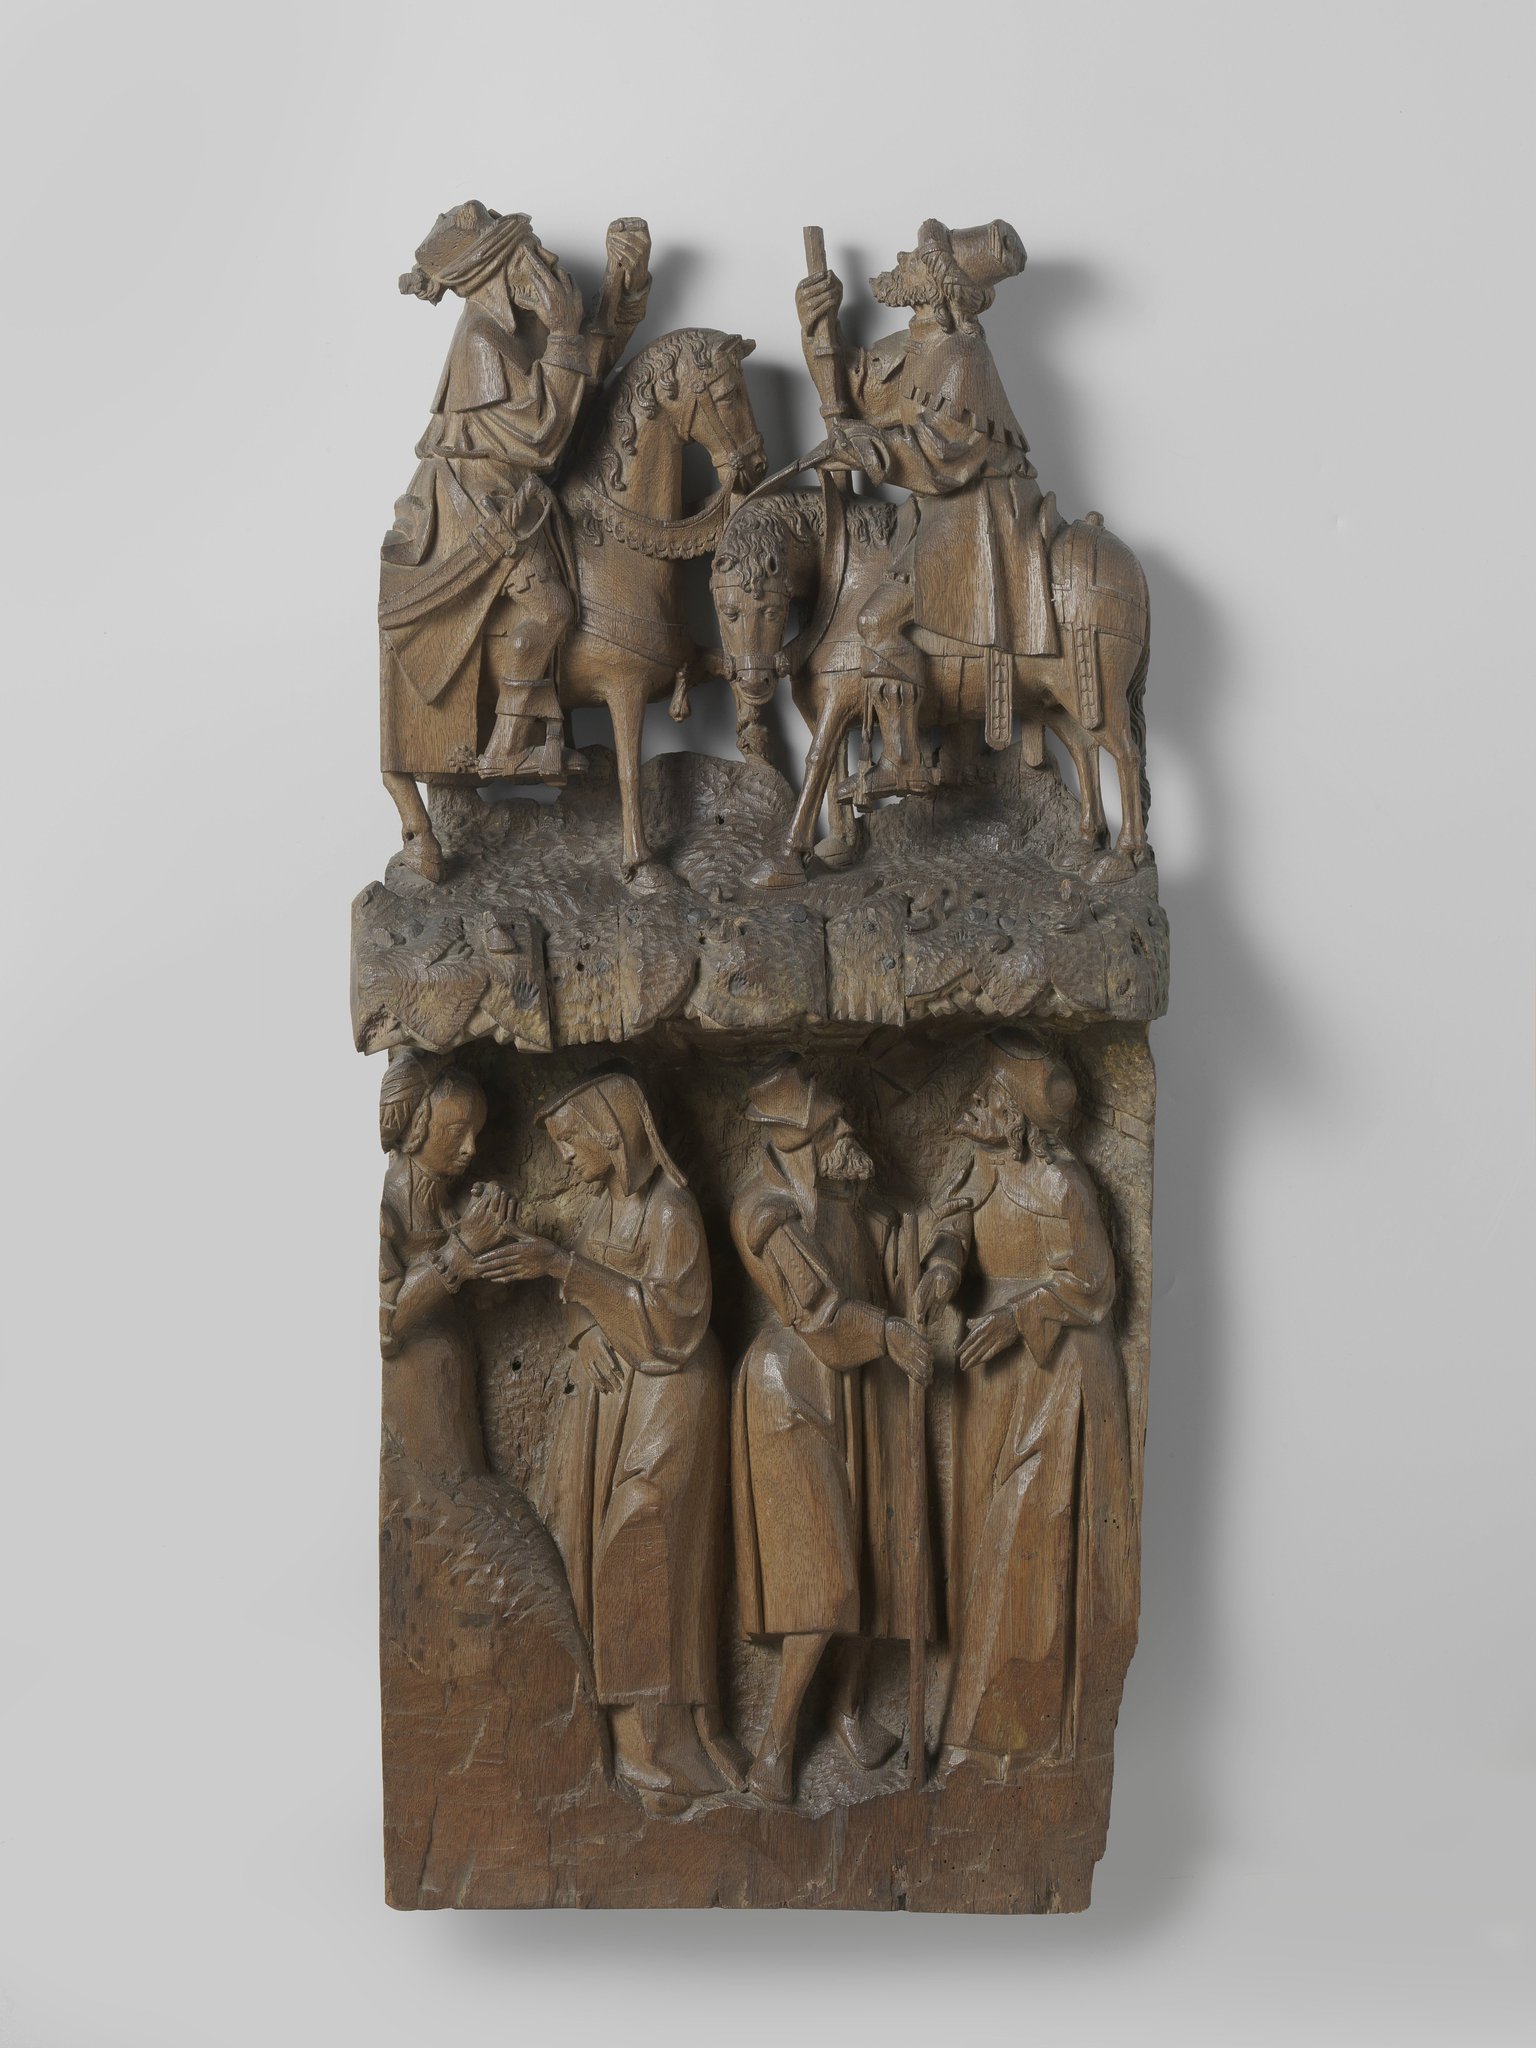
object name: sculpture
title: Landscape with Two Horsemen and Four Standing Figures, from a Calvary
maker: Anonymous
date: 1515-1525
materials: wood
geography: antwerp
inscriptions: mark, on Longinus’s headdresson Longinus’s headdress, branded: a hand (the Antwerp wood quality mark), mark, on three of the six ‘landscape’ pieces added to the upper grass mound, bramded: a hand (the Antwerp wood quality mark)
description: Fragment of a Calvary group. Oak, originally with polychromy. Antwerp, c. 1525.